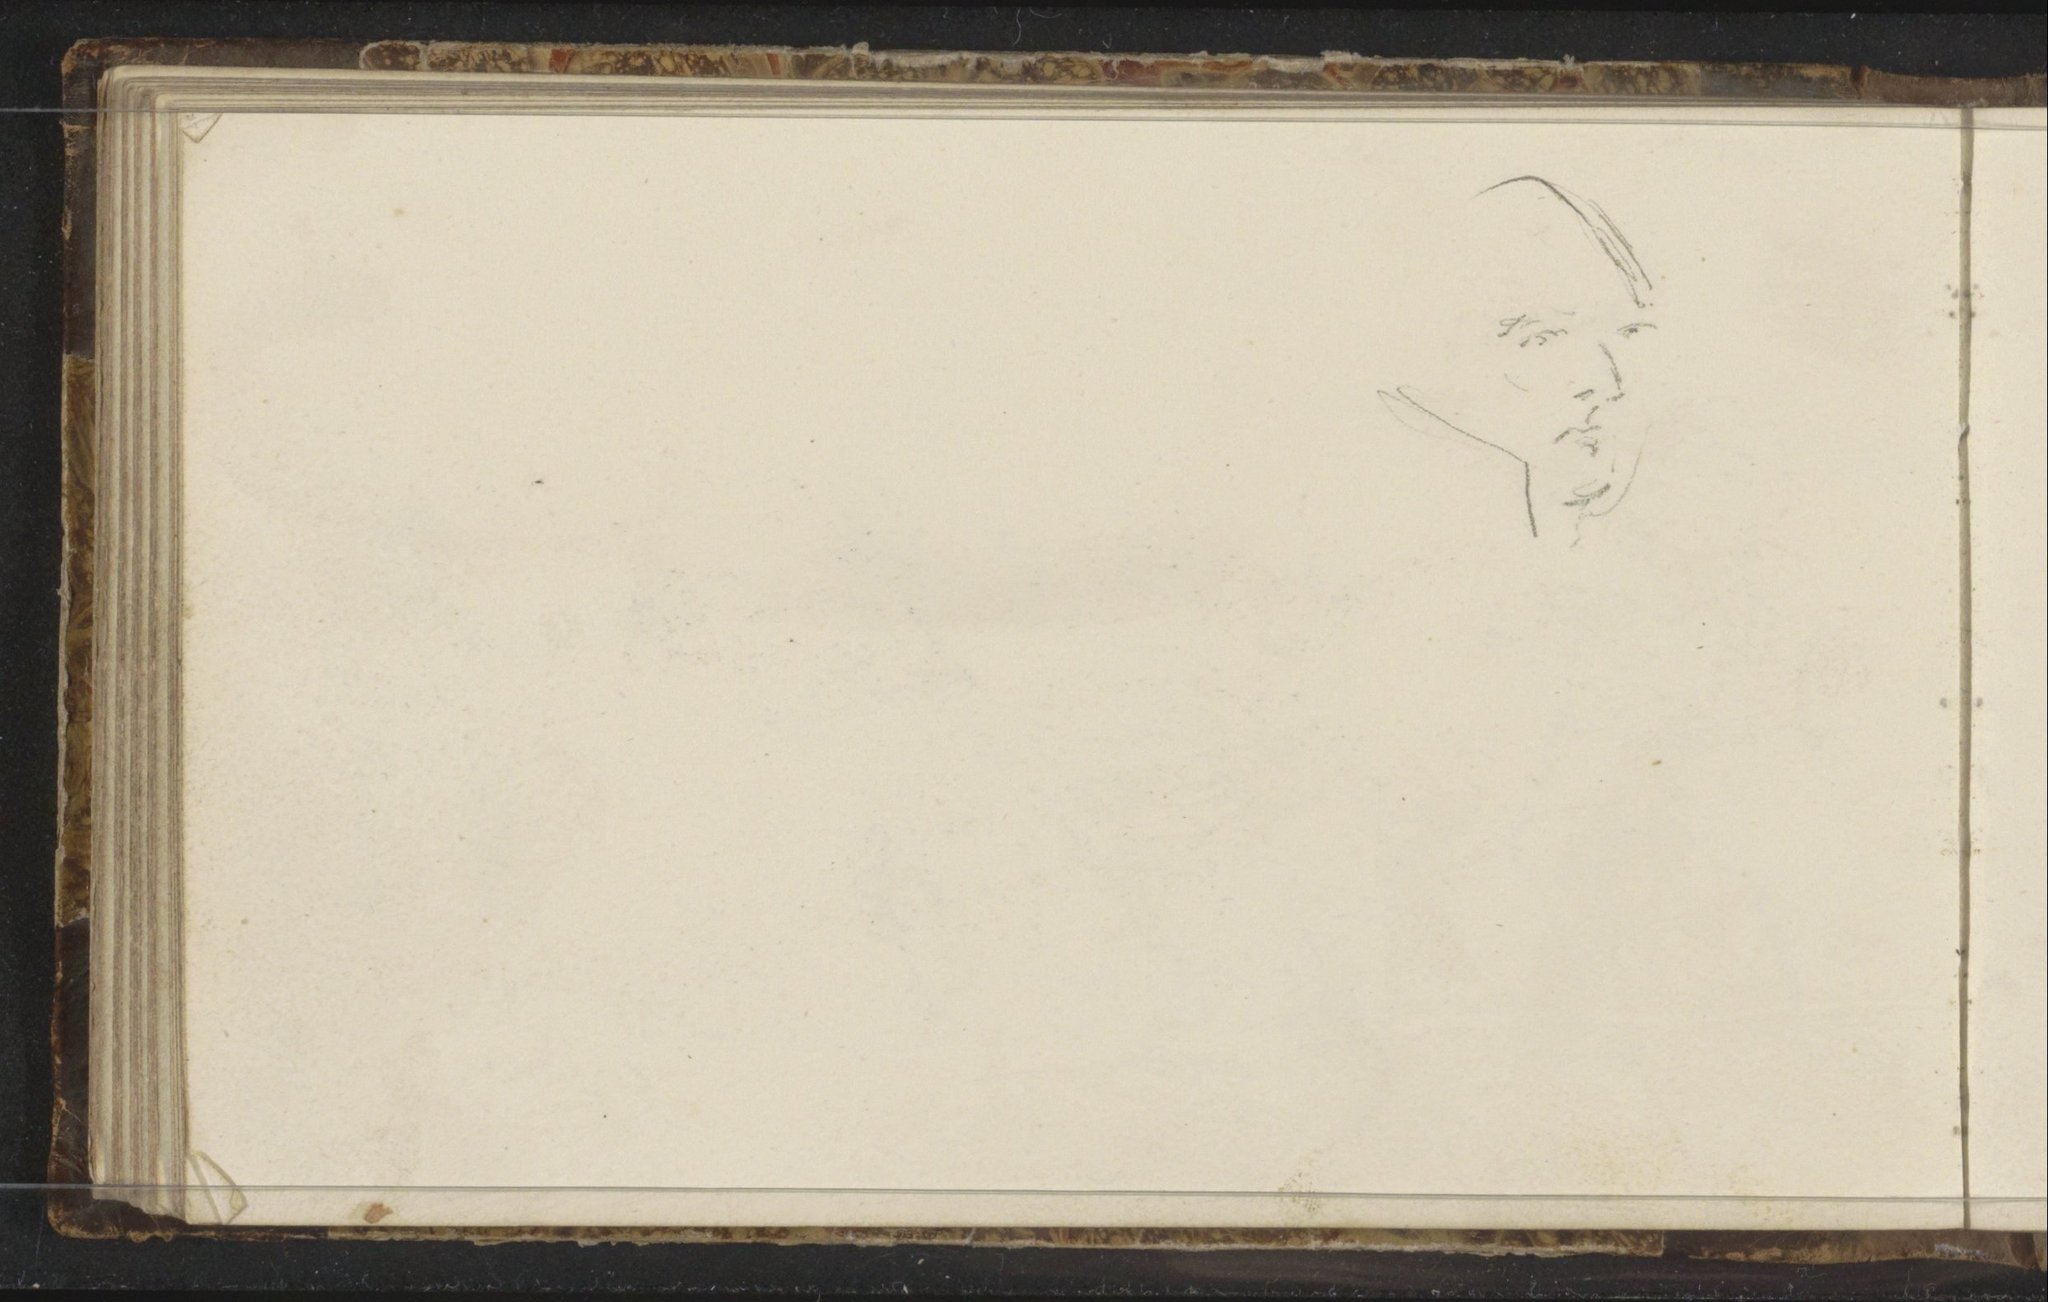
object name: sketchbook leaf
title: Kop van een man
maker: willem hendrik schmidt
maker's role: draughtsman, painter, print maker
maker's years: 1809-1849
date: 1819-1849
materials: paper, pencil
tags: head (human)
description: Blad 37 verso uit een schetsboek met 60 bladen.